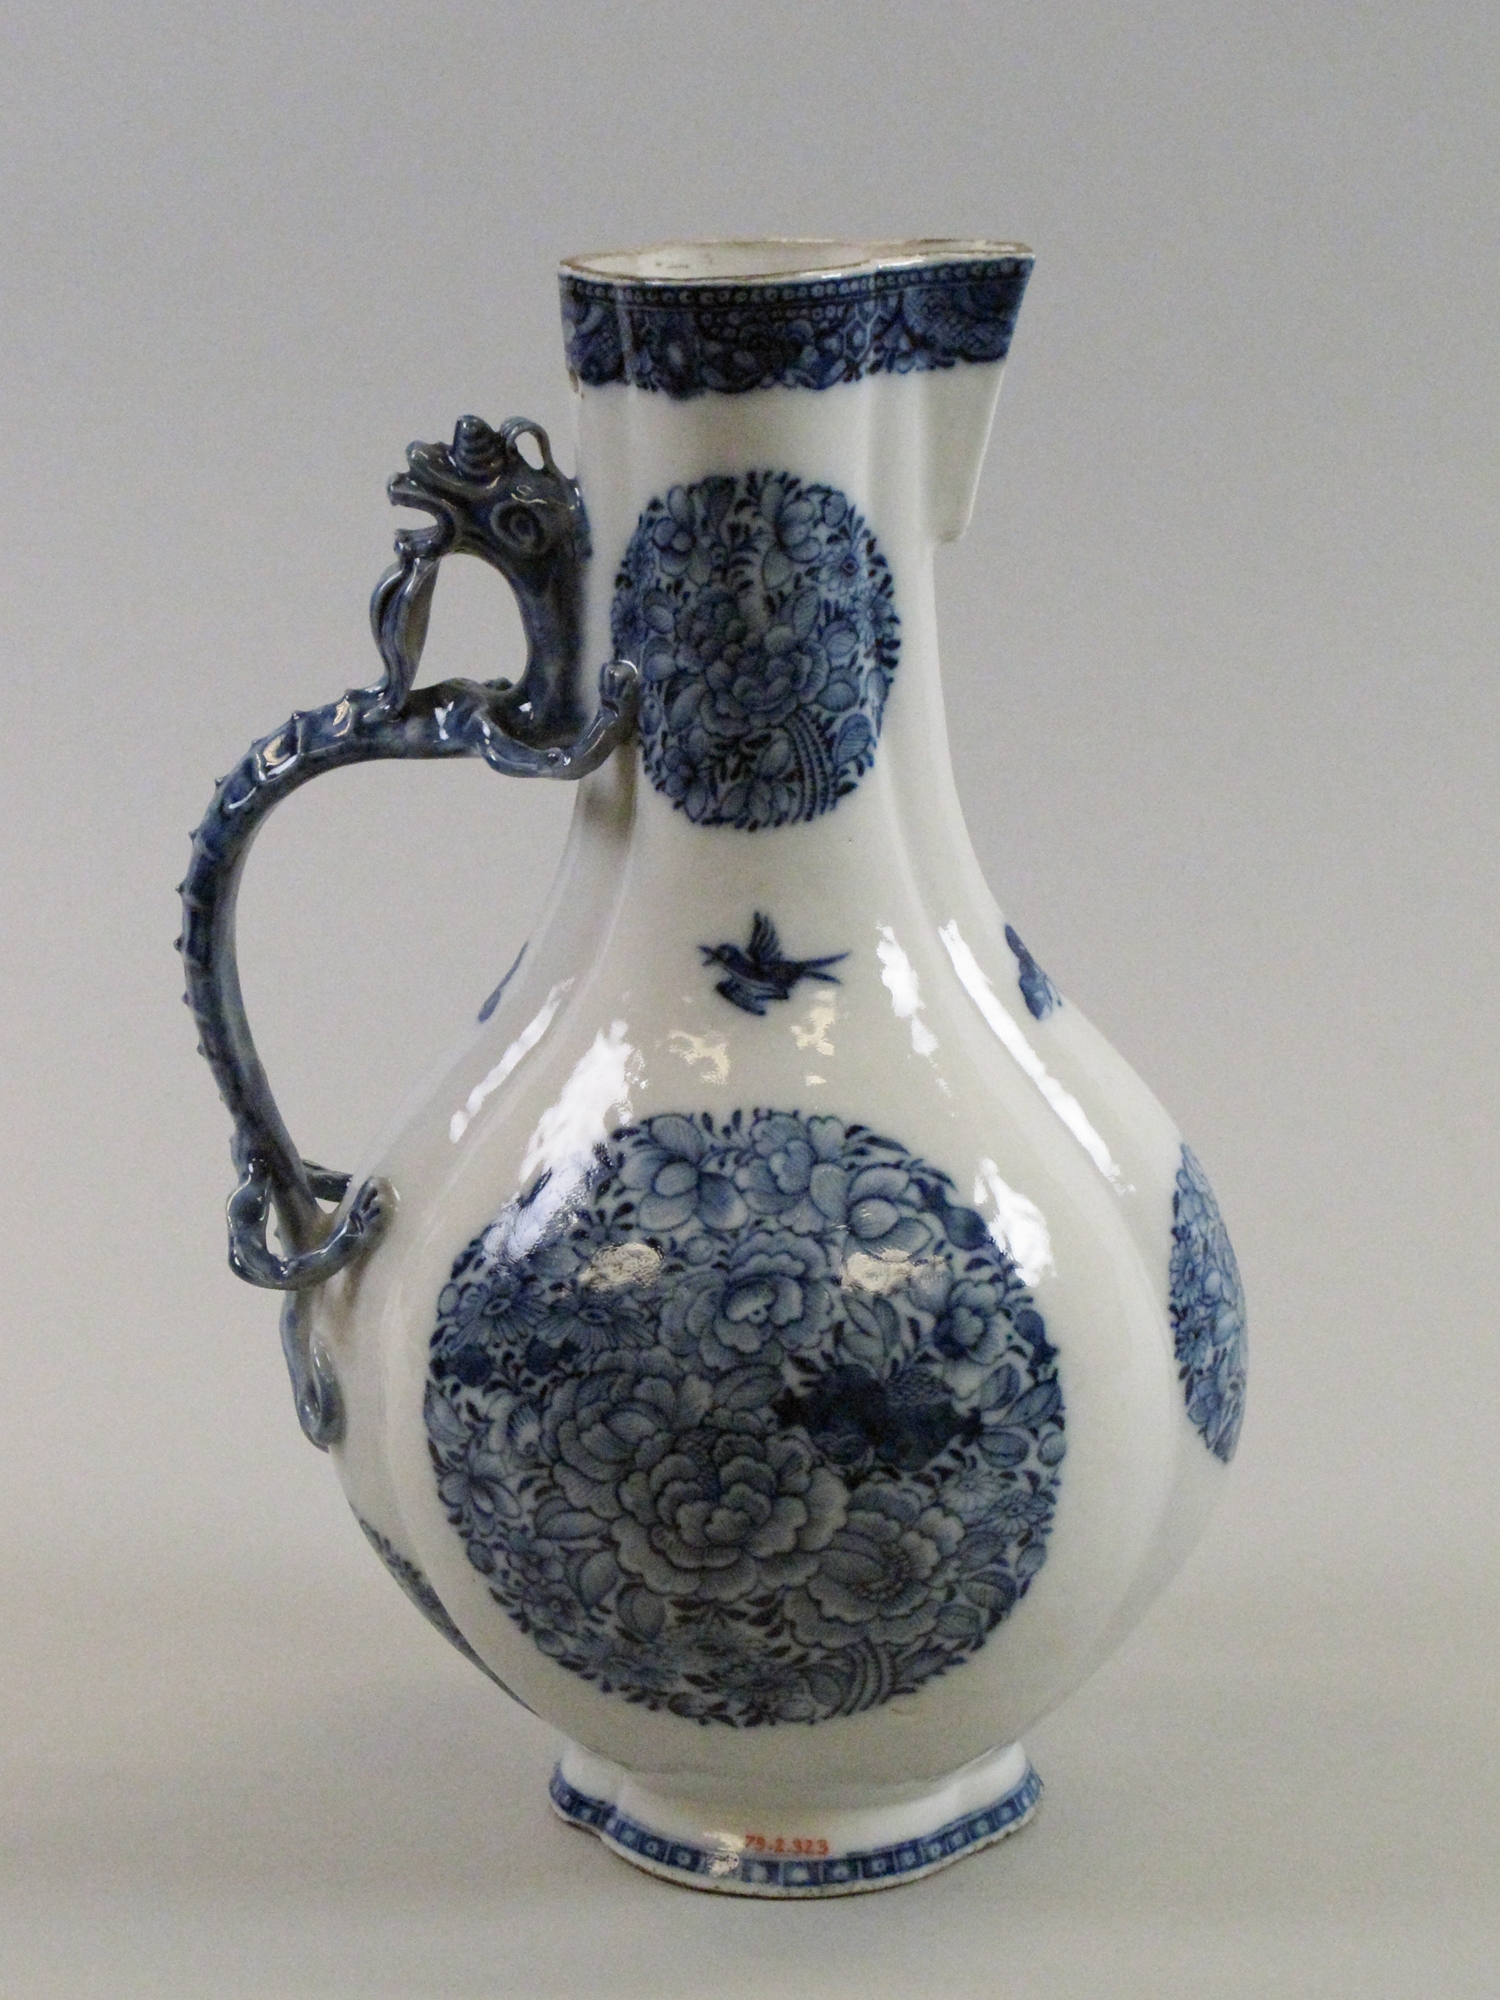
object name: jug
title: Jug with dragon handle and floral madellions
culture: chinese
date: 1701-1800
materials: cobalt, soft paste porcelain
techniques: painting, underglaze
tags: birds,flowers